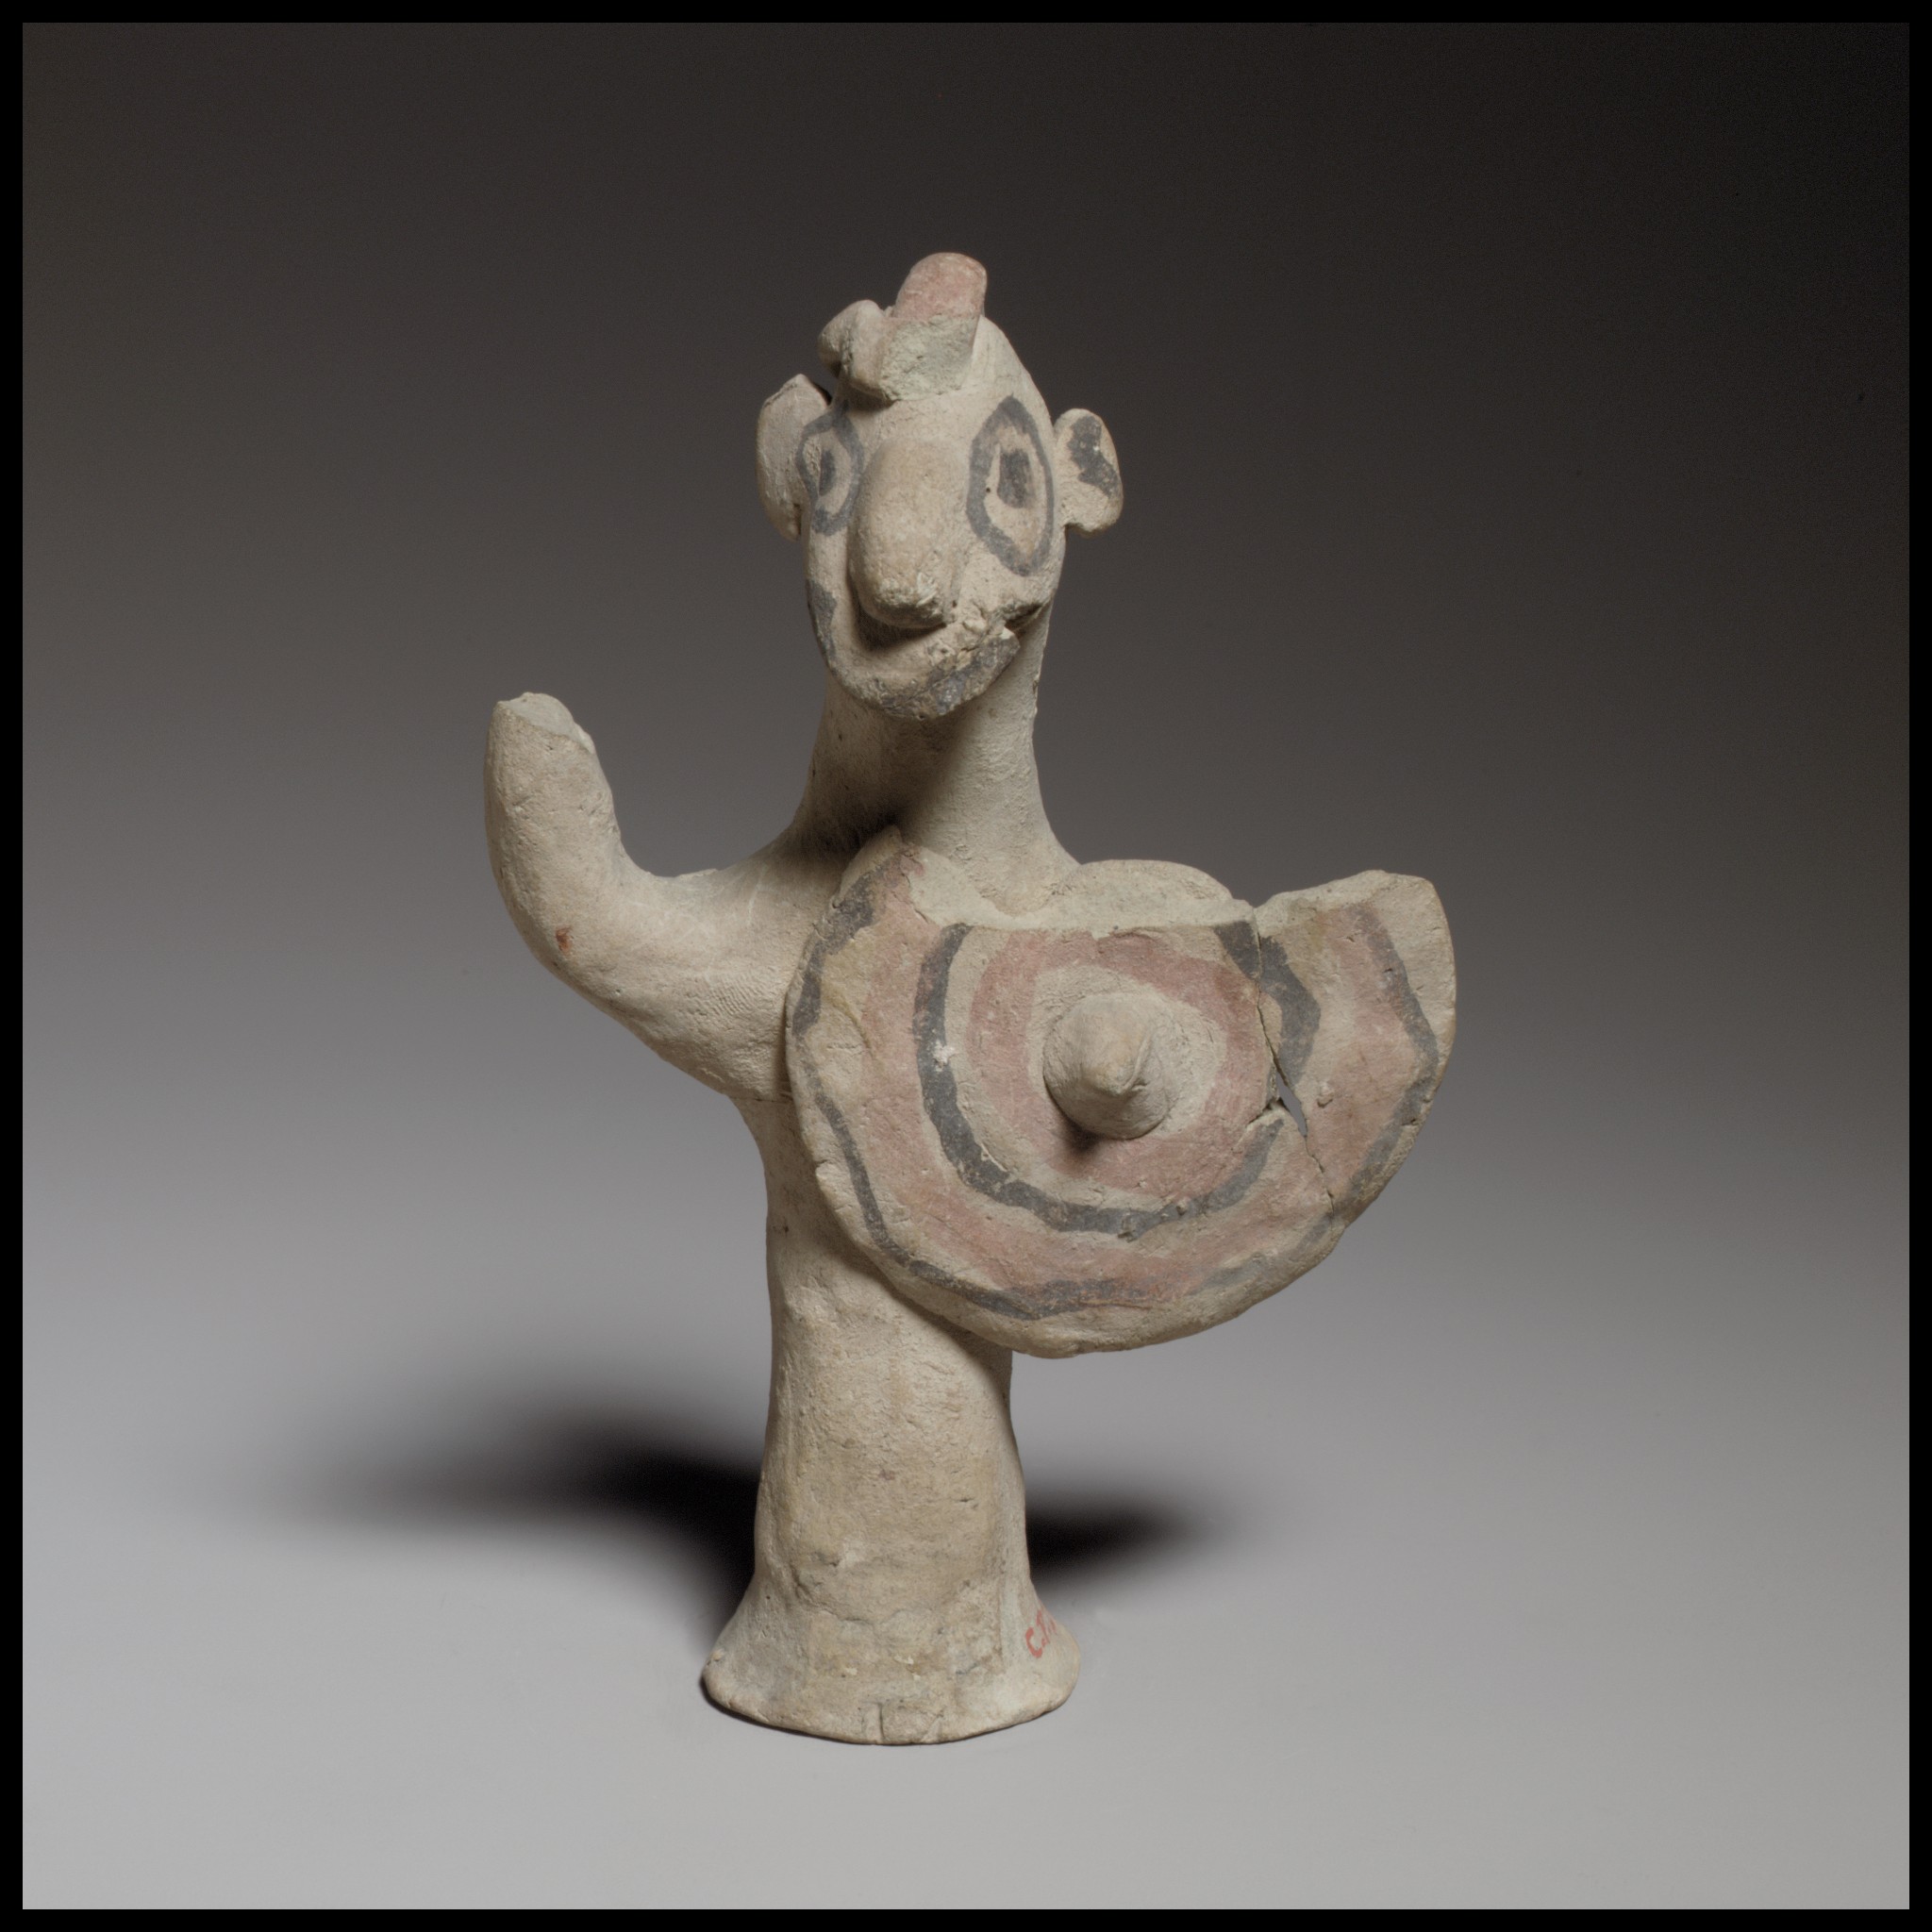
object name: statue of a warrior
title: Shield bearer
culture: cypriot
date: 600-480 BCE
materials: terracotta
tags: human figures,shields